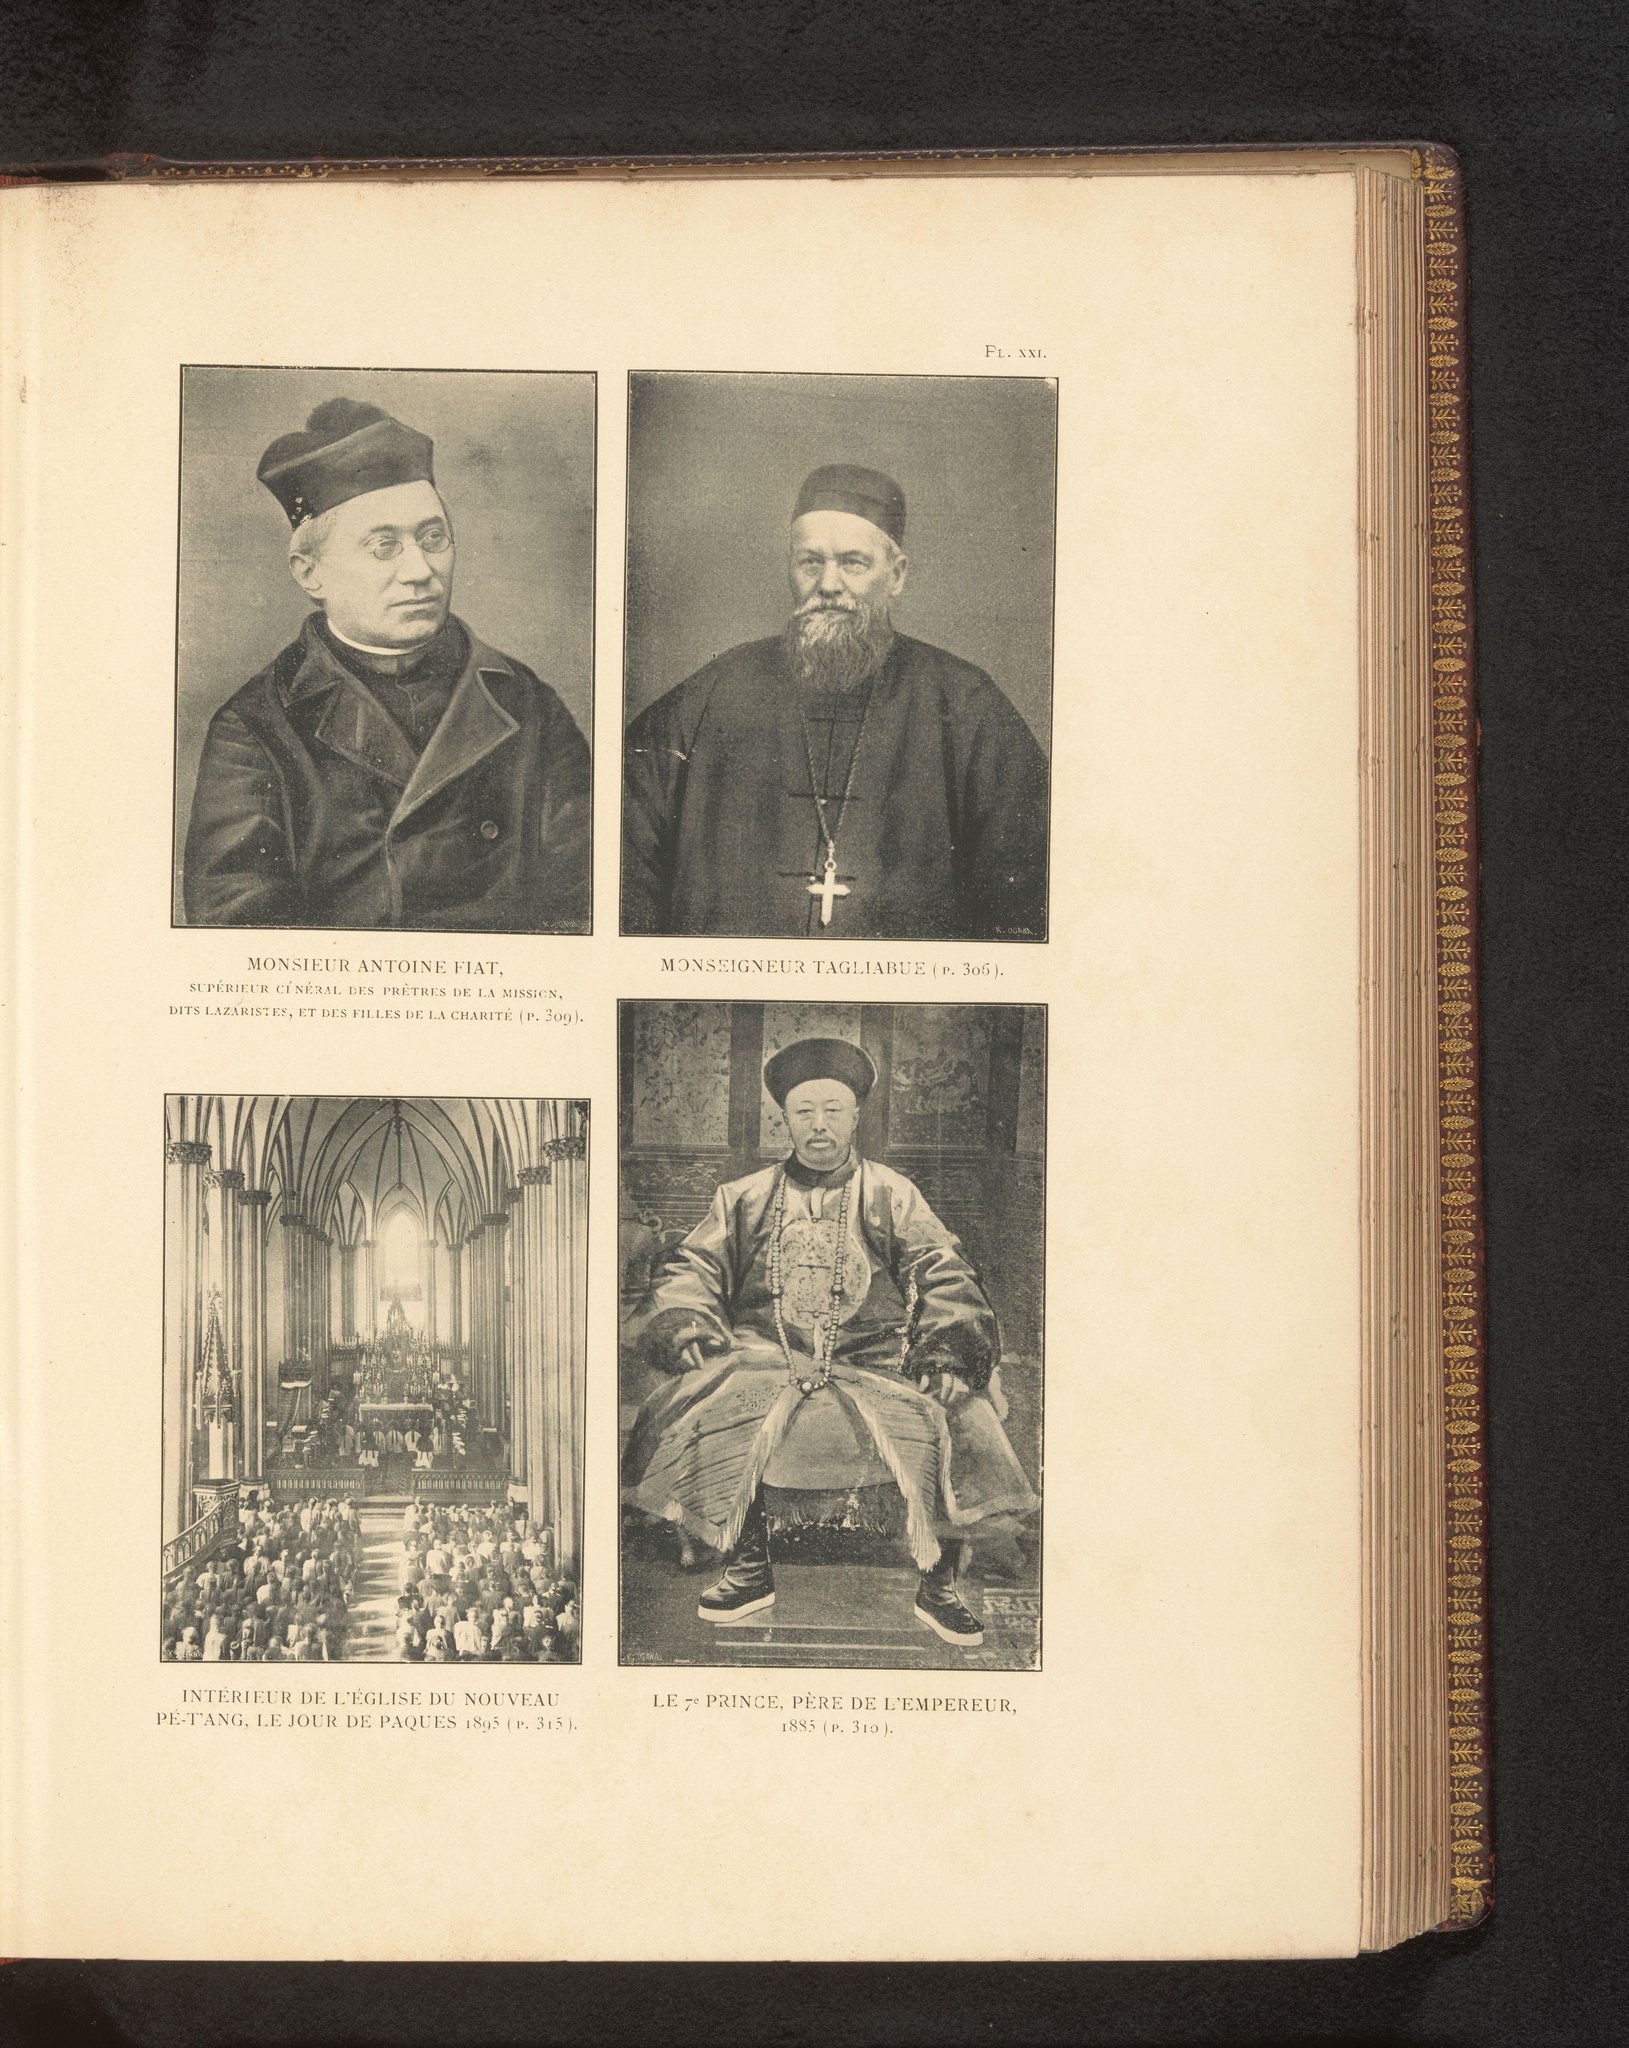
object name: page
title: Portret van Antonie Fiat, Portret van Tagliabue, De paasmis in de Xishiku-kerk in 1895 en Portret van de zevende Prins, vader van de Keizer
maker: Anonymous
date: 1892-1897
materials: paper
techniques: autotype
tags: historical persons, interior of church